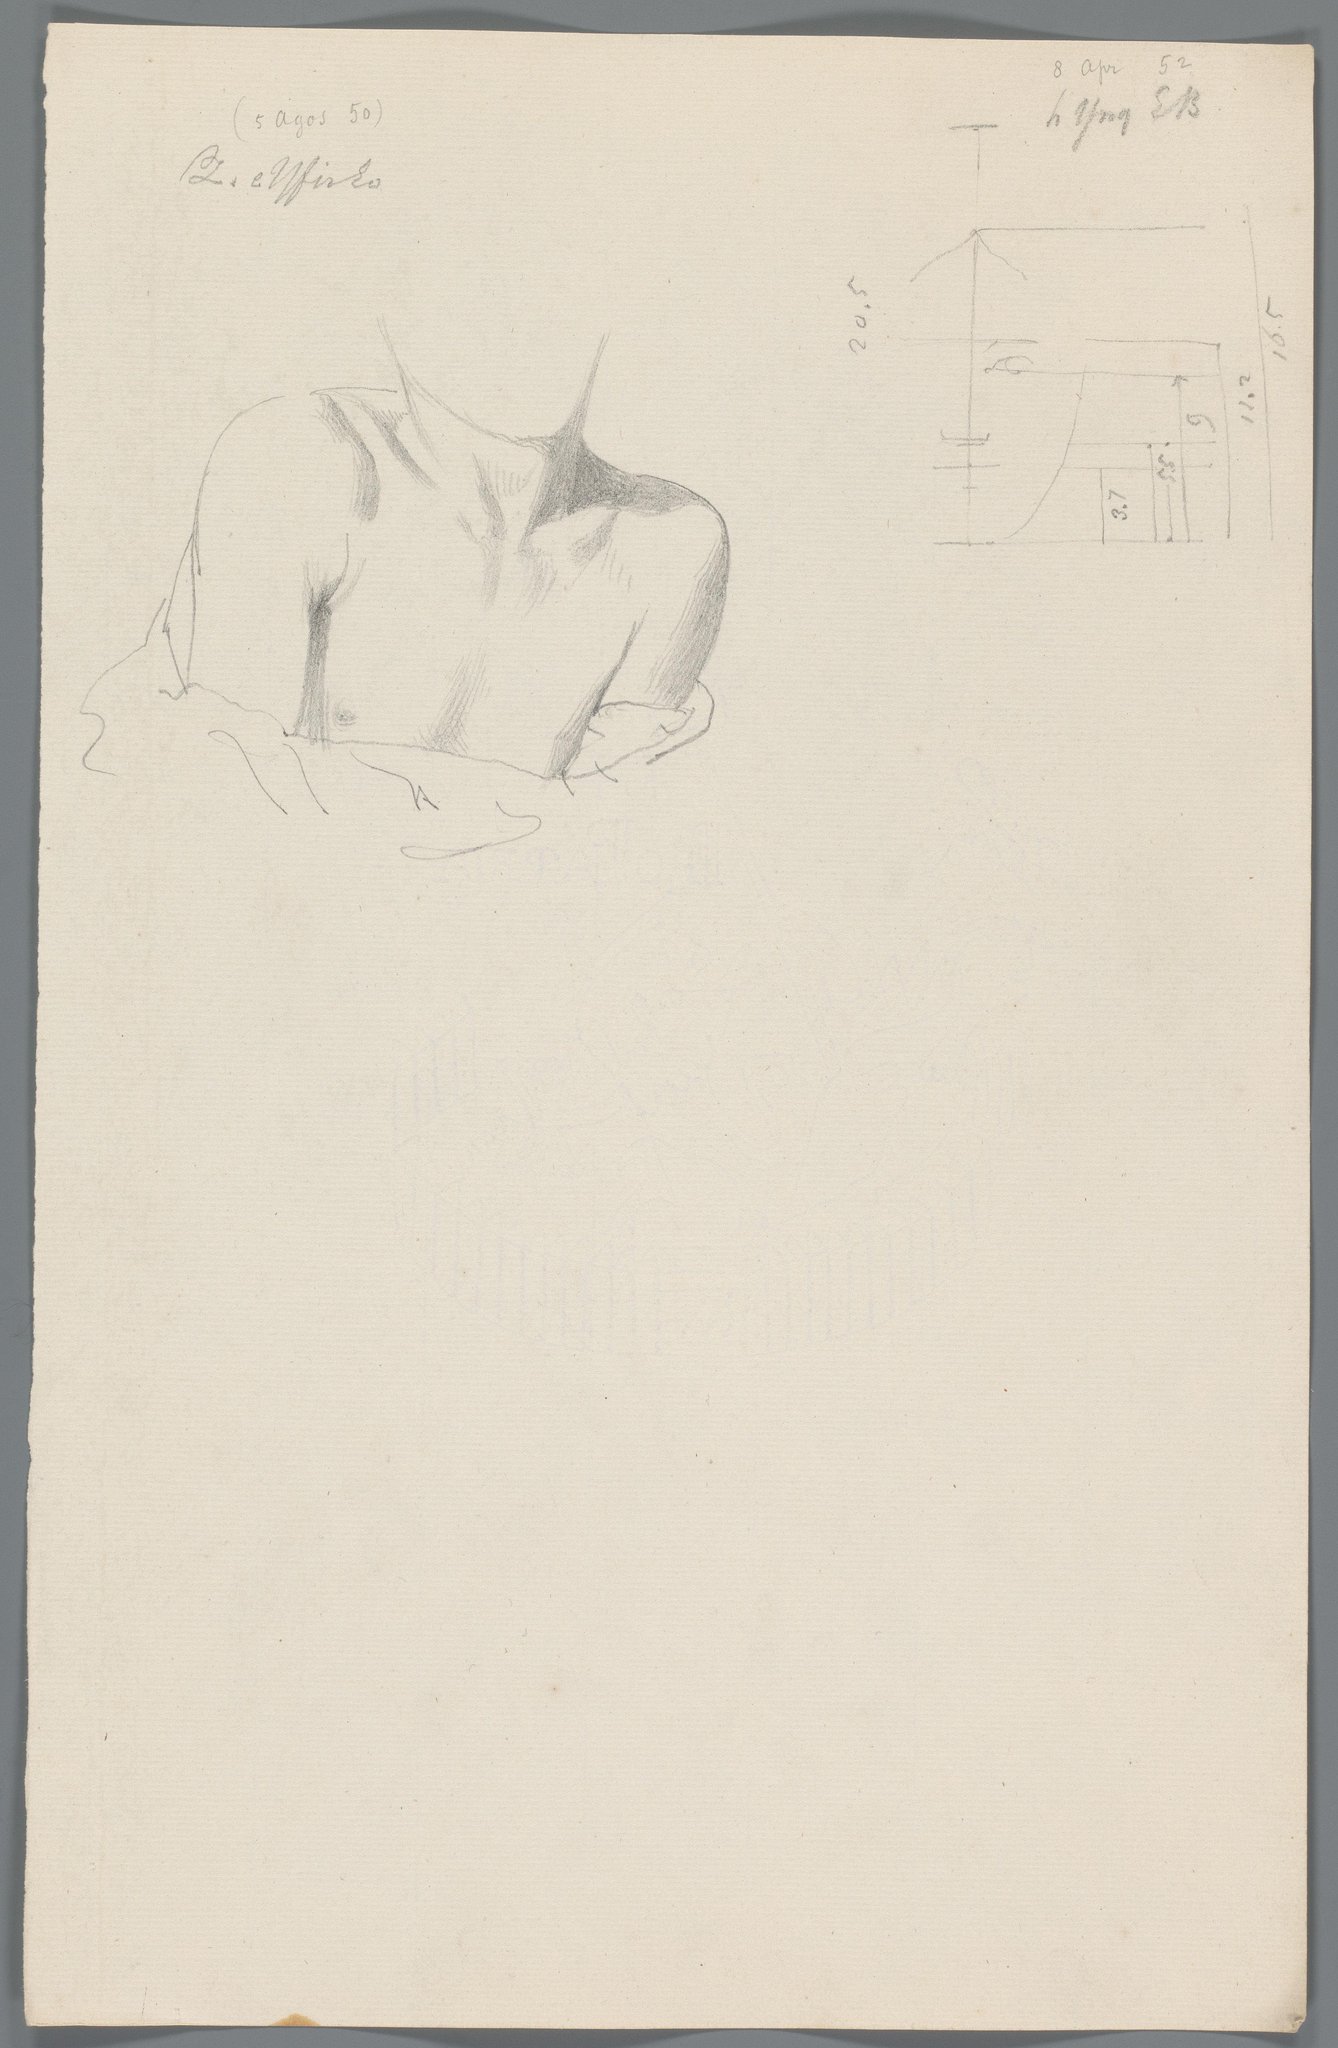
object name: drawing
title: Studie van een ontbloot bovenlijf en van een gezicht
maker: jacobus everhardus josephus van den berg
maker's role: draughtsman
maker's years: 1802-1861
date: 1852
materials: paper, pencil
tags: face, chest, bust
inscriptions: inscription: ‘8 apr 52/ h Yng EB’